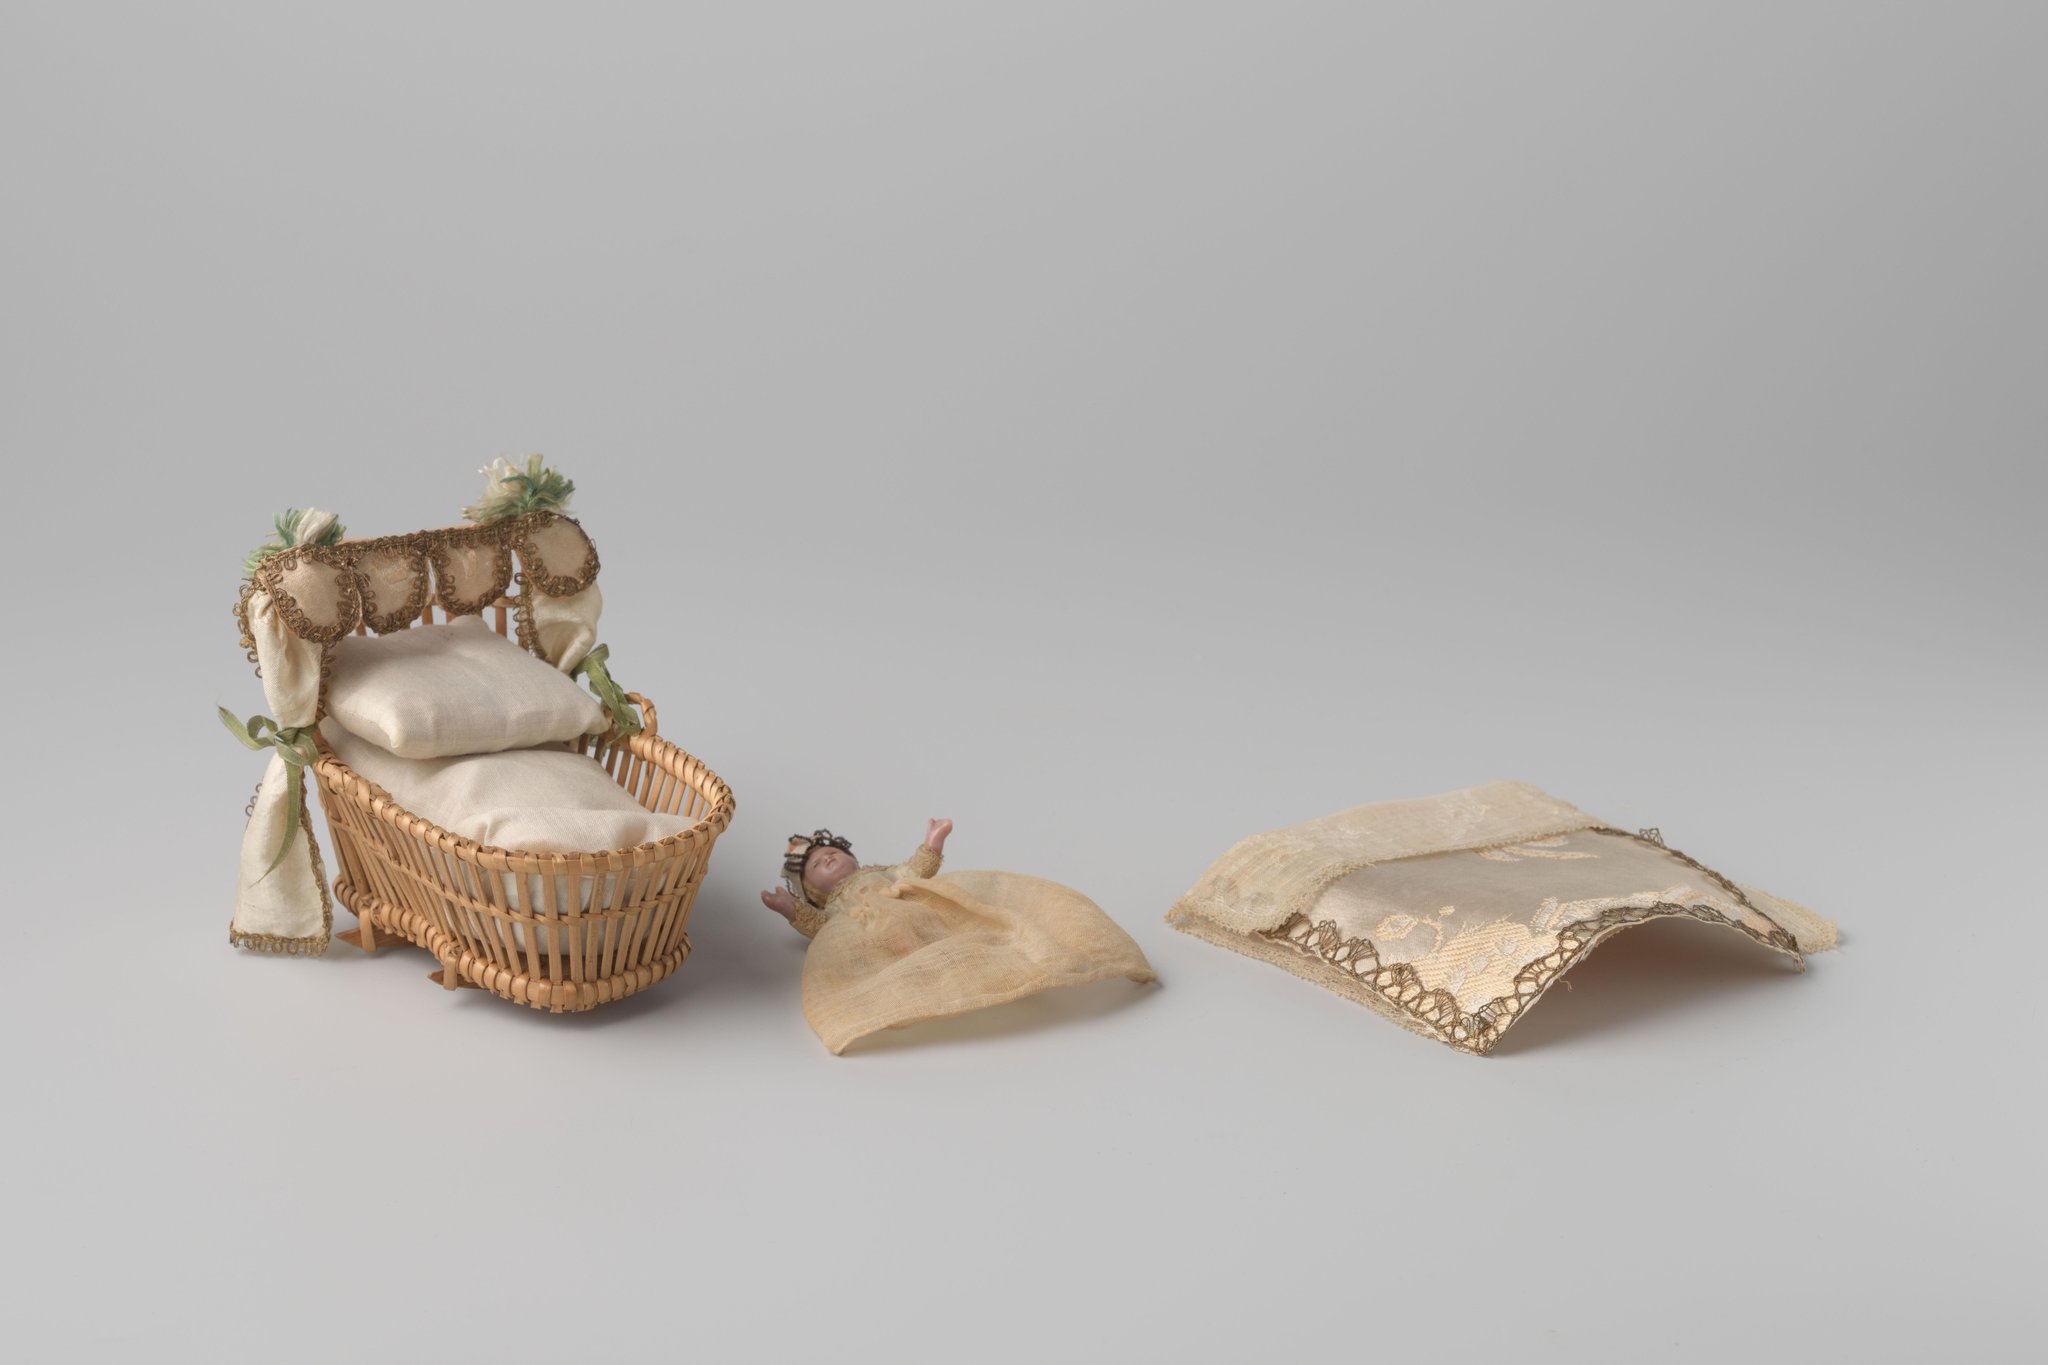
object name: miniature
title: Wieg van wilgentenen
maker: Anonymous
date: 1700-1749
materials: gold thread, plant material, silk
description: Wieg van wilgentenen met bodem en twee schenkels van without. De wanden en recht afgeslotem vaste kap een open constructie van spijlen. Aan de kap zijn een de voorzijde een geschulpte val en twee gordijnen vastgenaaid, vervaardigd van een stuk zijde, van hetzelfde soort als het wiegekleed, en van witte taftzijde (gordijnen), beide afgezet met gouddraad passement. Op de kap zijn twee groen-witte kwasten vastgezet. De gordijnen zijn vastgestrikt met groen met wit afgebiesd lint, een identiek lint is aan de wieg geknoopt als schommellint.